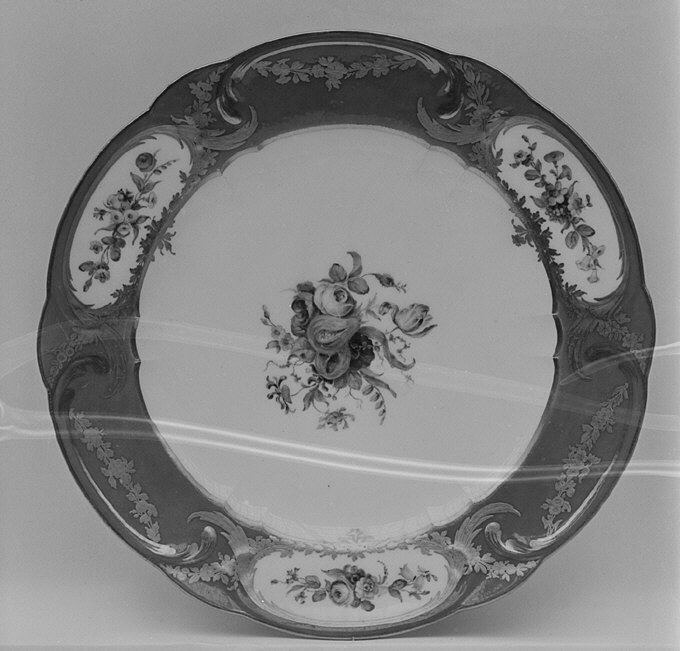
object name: plate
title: Plate (Assiette à palmes) (1 of 102) (part of a service)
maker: sèvres manufactory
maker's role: manufactory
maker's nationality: french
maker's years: 1740-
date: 1780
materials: soft paste porcelain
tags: flowers